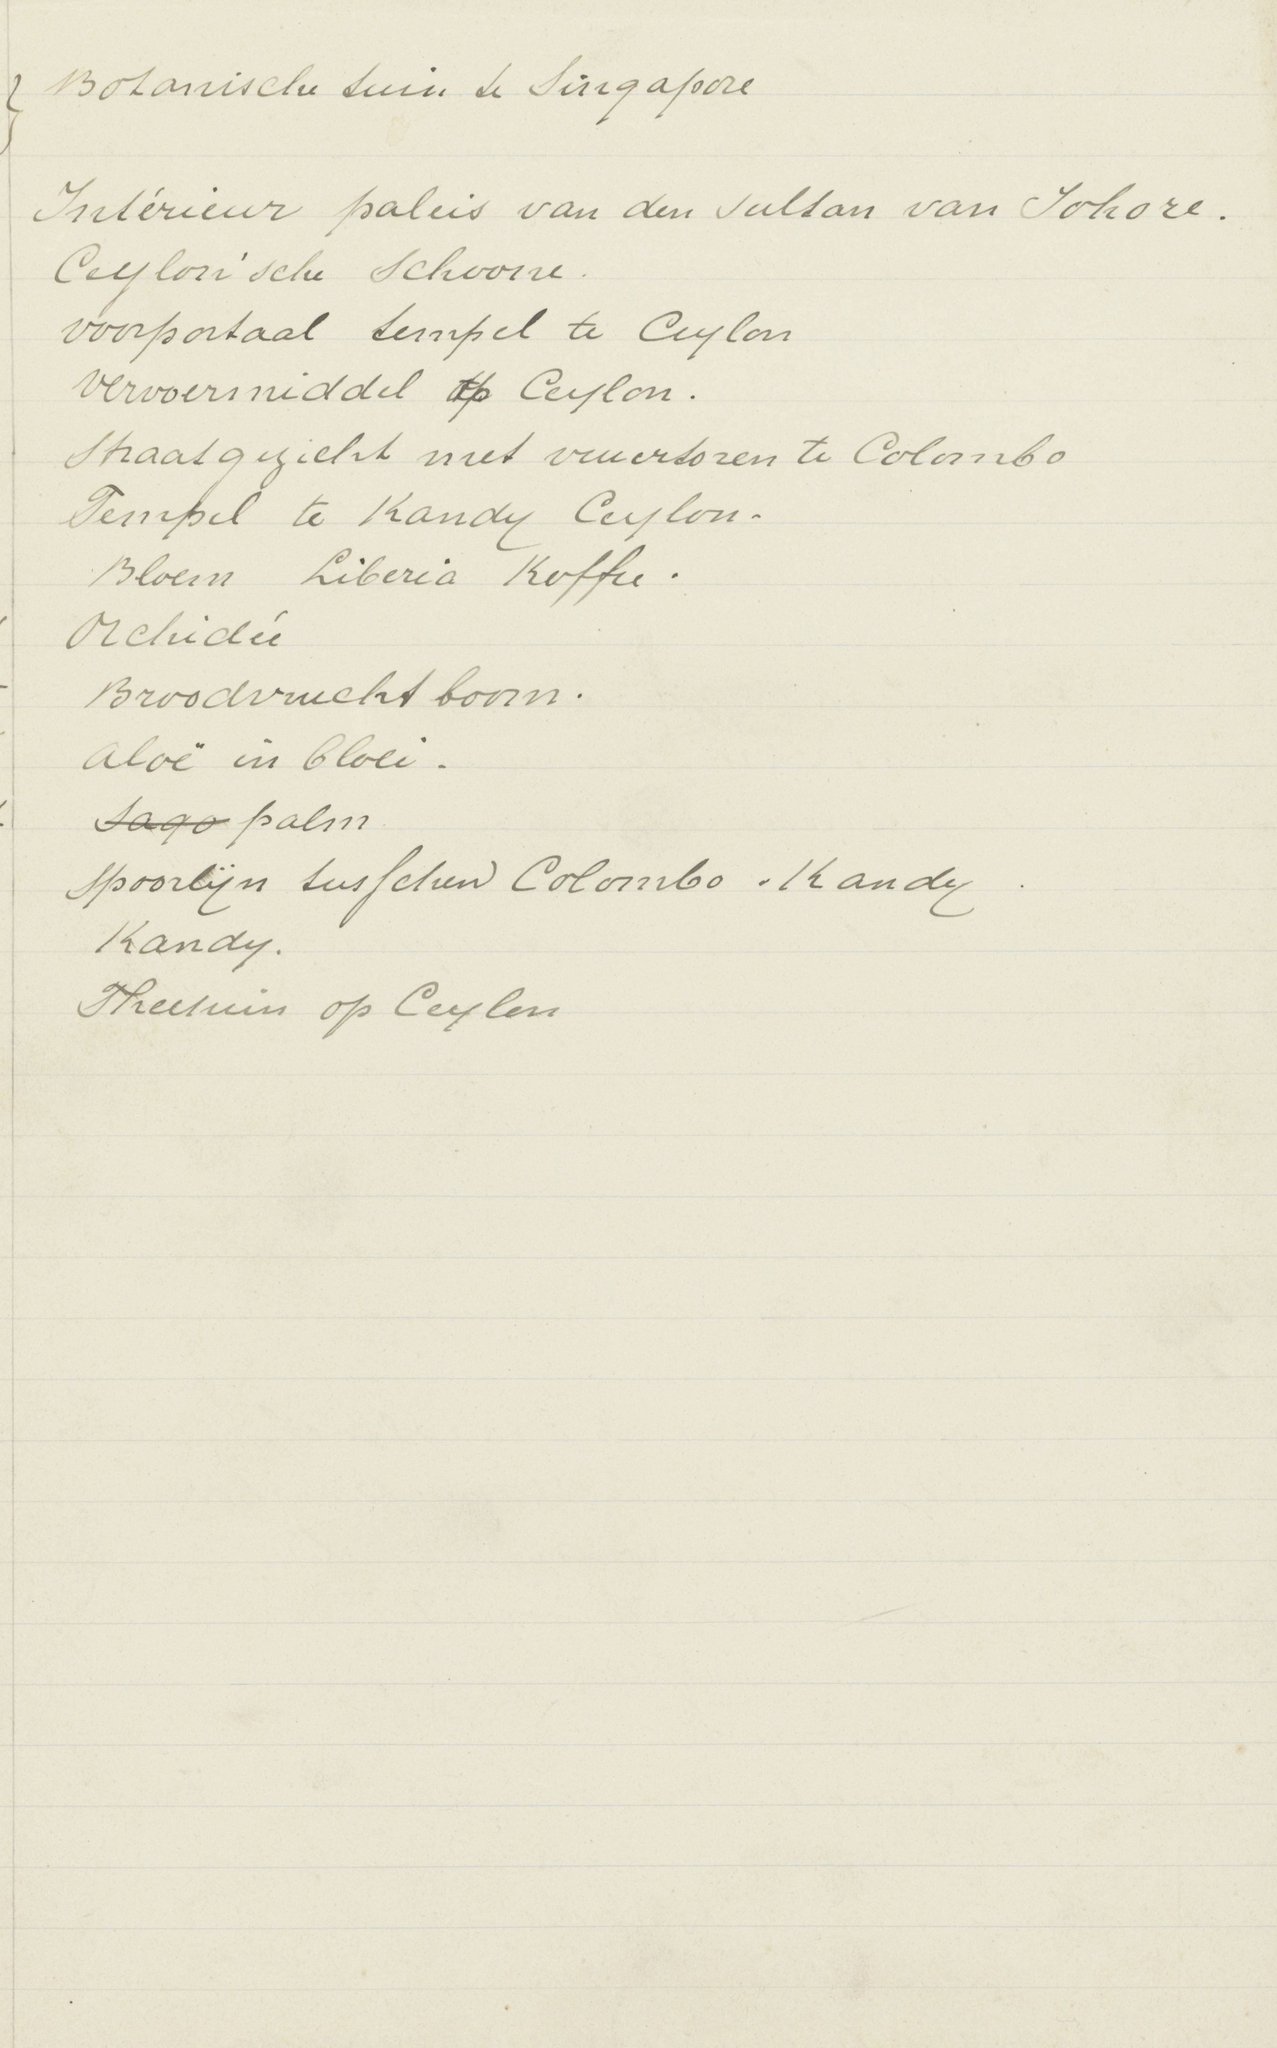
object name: list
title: Lijst met in het album afgebeelde onderwerpen (35 t/m 50)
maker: Anonymous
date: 1900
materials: paper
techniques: writing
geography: netherlands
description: Onderdeel van Album met 50 foto's van een reis door Zuidoost-Azië.